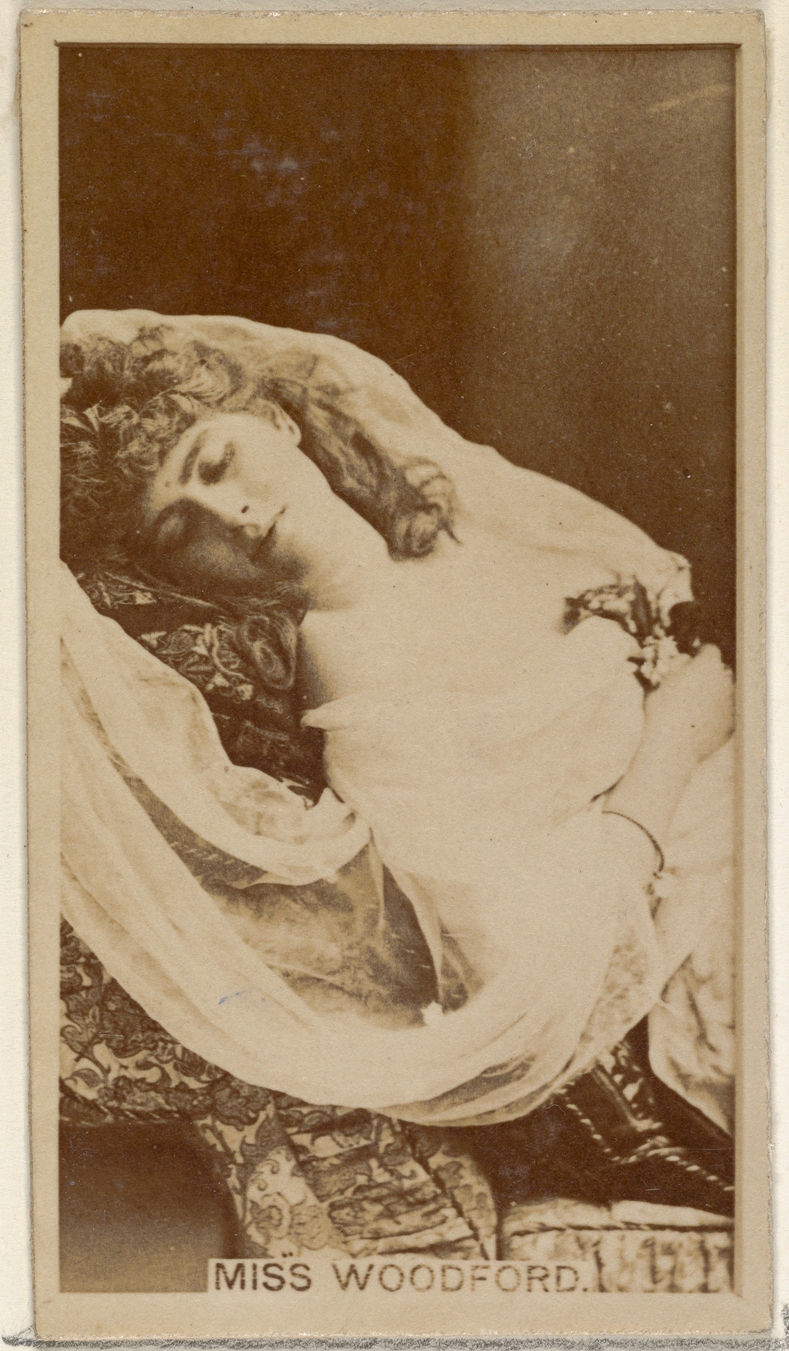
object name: photograph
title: Miss Woodford, from the Actors and Actresses series (N45, Type 8) for Virginia Brights Cigarettes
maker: allen & ginter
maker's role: publisher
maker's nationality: american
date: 1888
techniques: albumen silver print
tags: sleeping,women